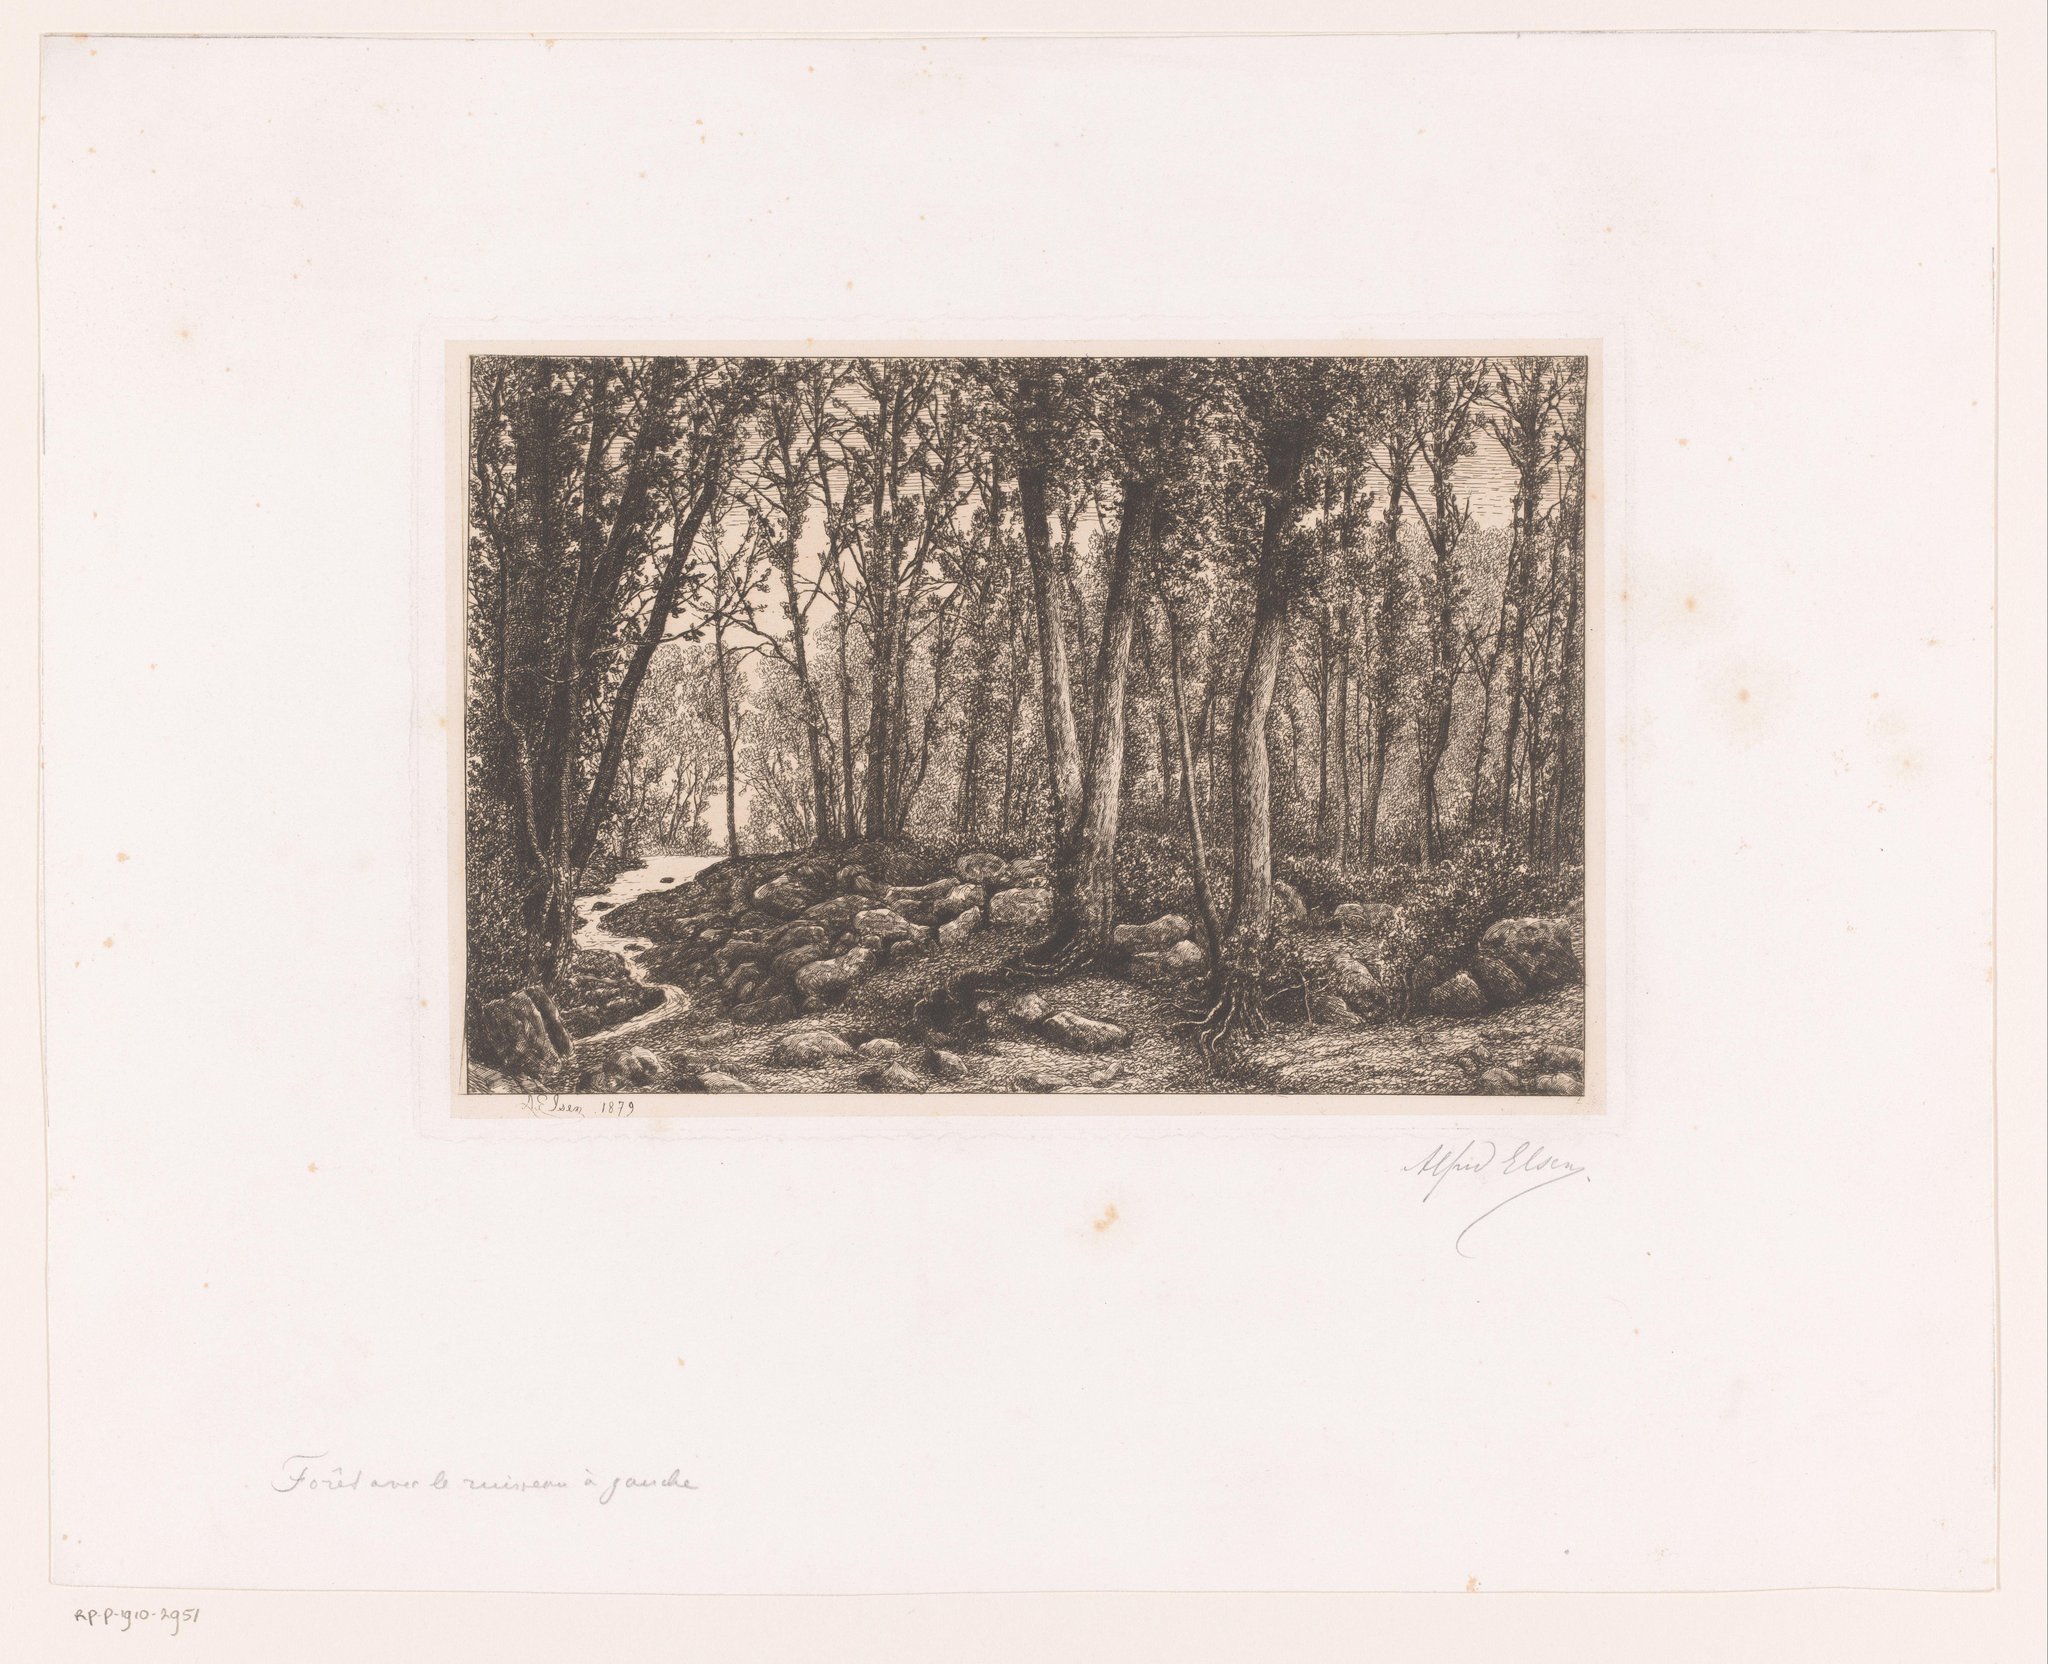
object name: print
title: Bosgezicht met links een beek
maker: alfred elsen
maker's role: painter, print maker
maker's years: 1850-1914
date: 1879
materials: paper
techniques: etching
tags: forest, wood, brook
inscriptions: collector's mark: Lugt 2228